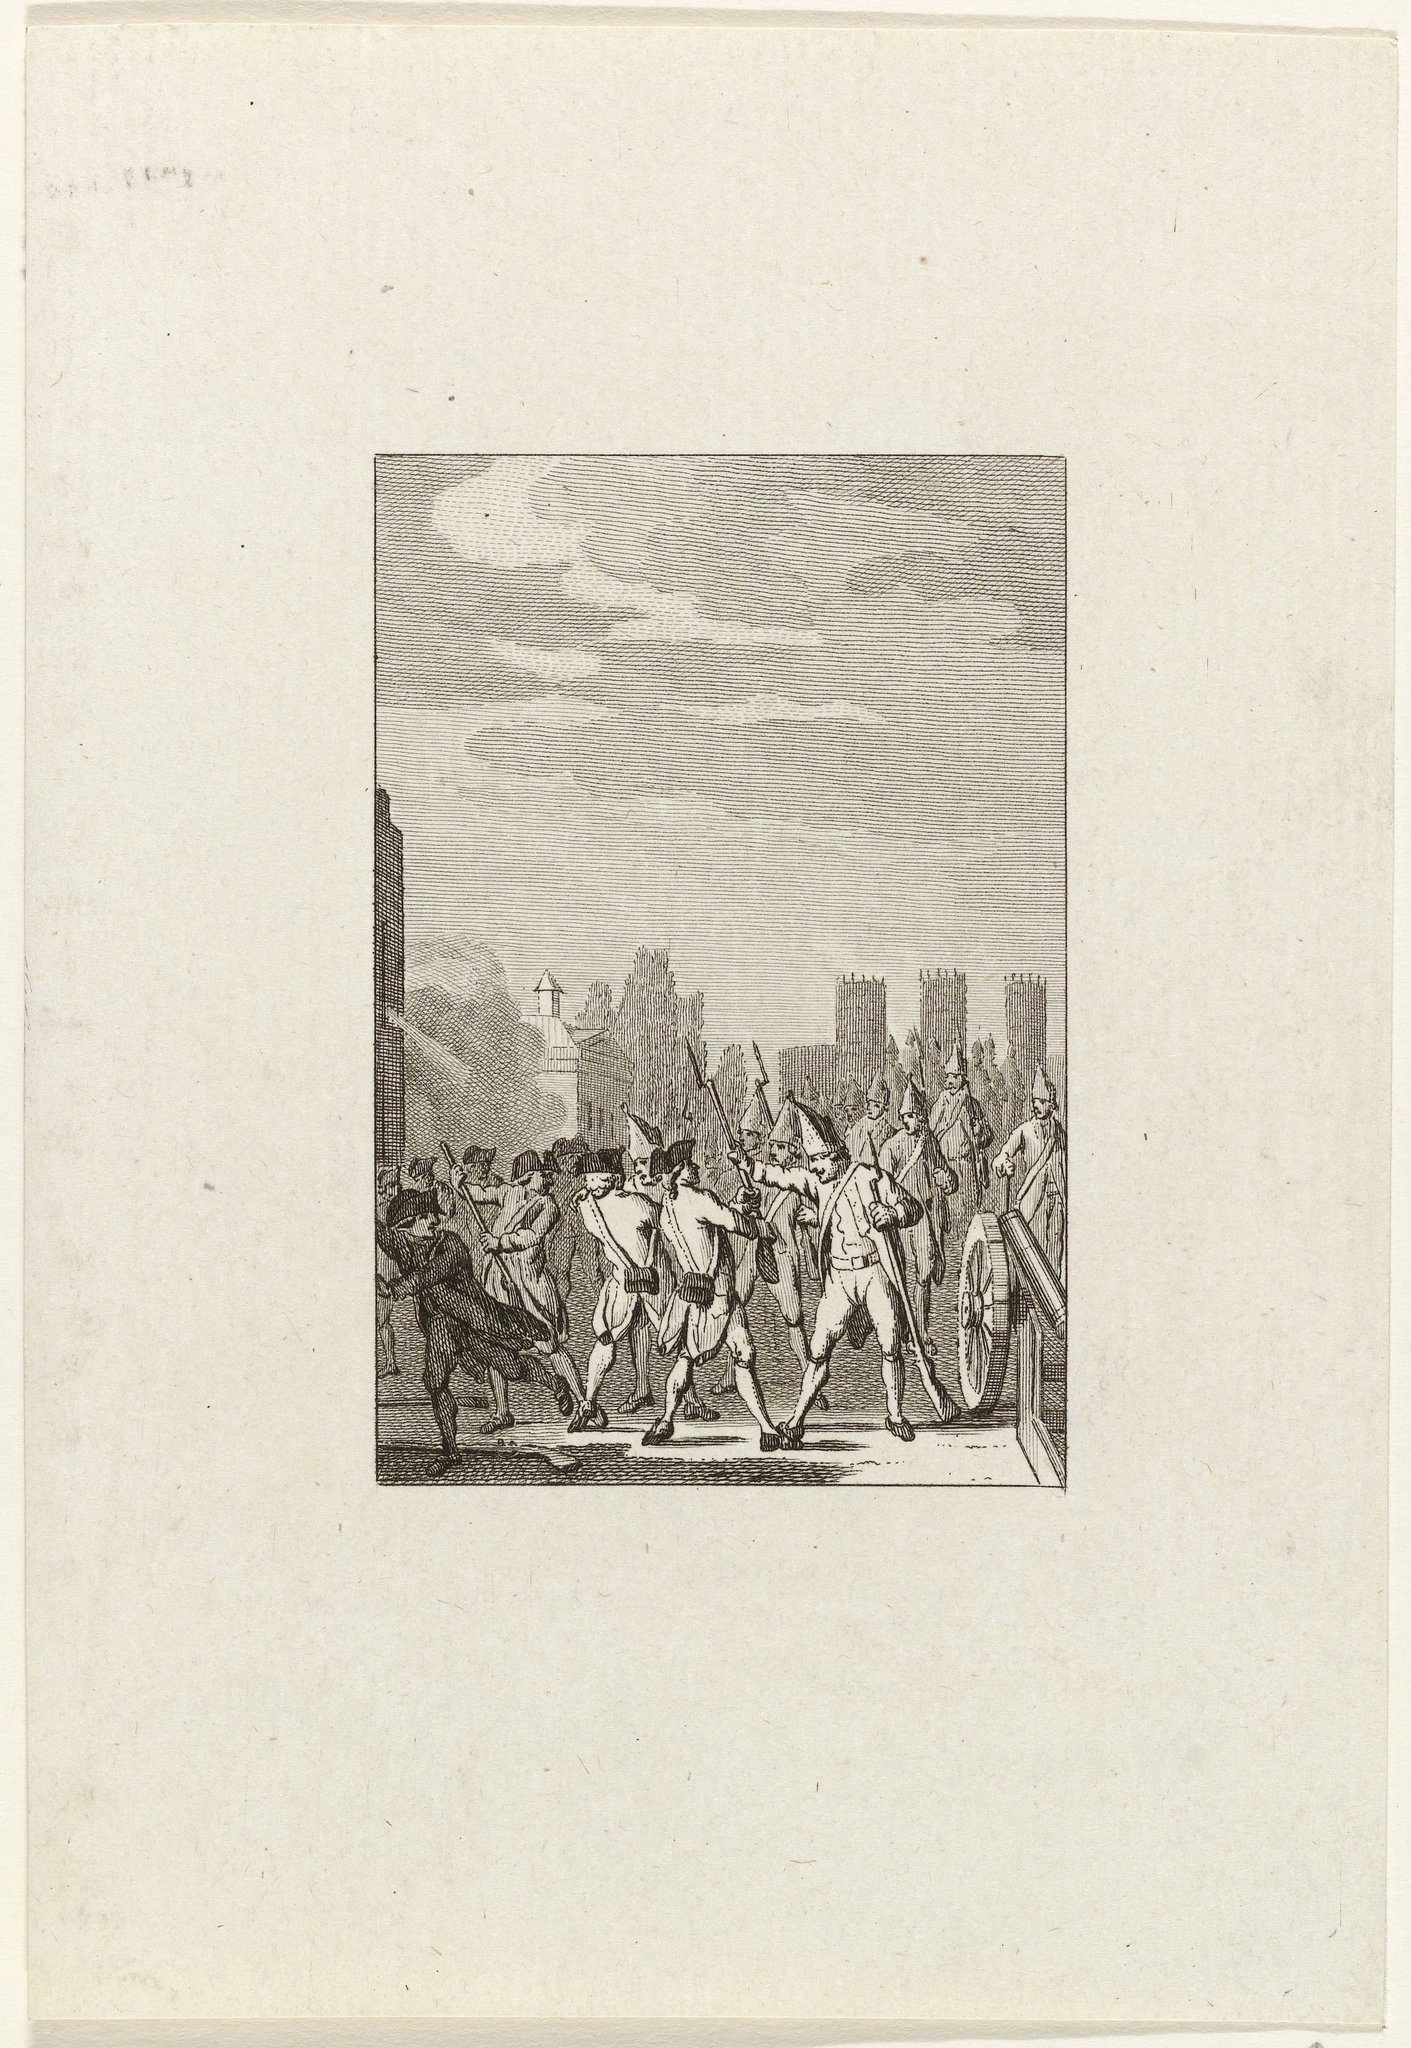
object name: history print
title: Gevecht bij Halfweg, 1787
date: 1787-1795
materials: paper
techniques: etching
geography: northern netherlands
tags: surprise attack (stratagem)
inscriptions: collector's mark: Lugt 2228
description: Gebruikt als illustratie in: J. Fokke, Geschiedenissen der Vereenigde Nederlanden voor de vaderlandsche jeugd, Johannes Allart, Amsterdam 1783-1795, 25 delen, dl. 20, pl. 1.